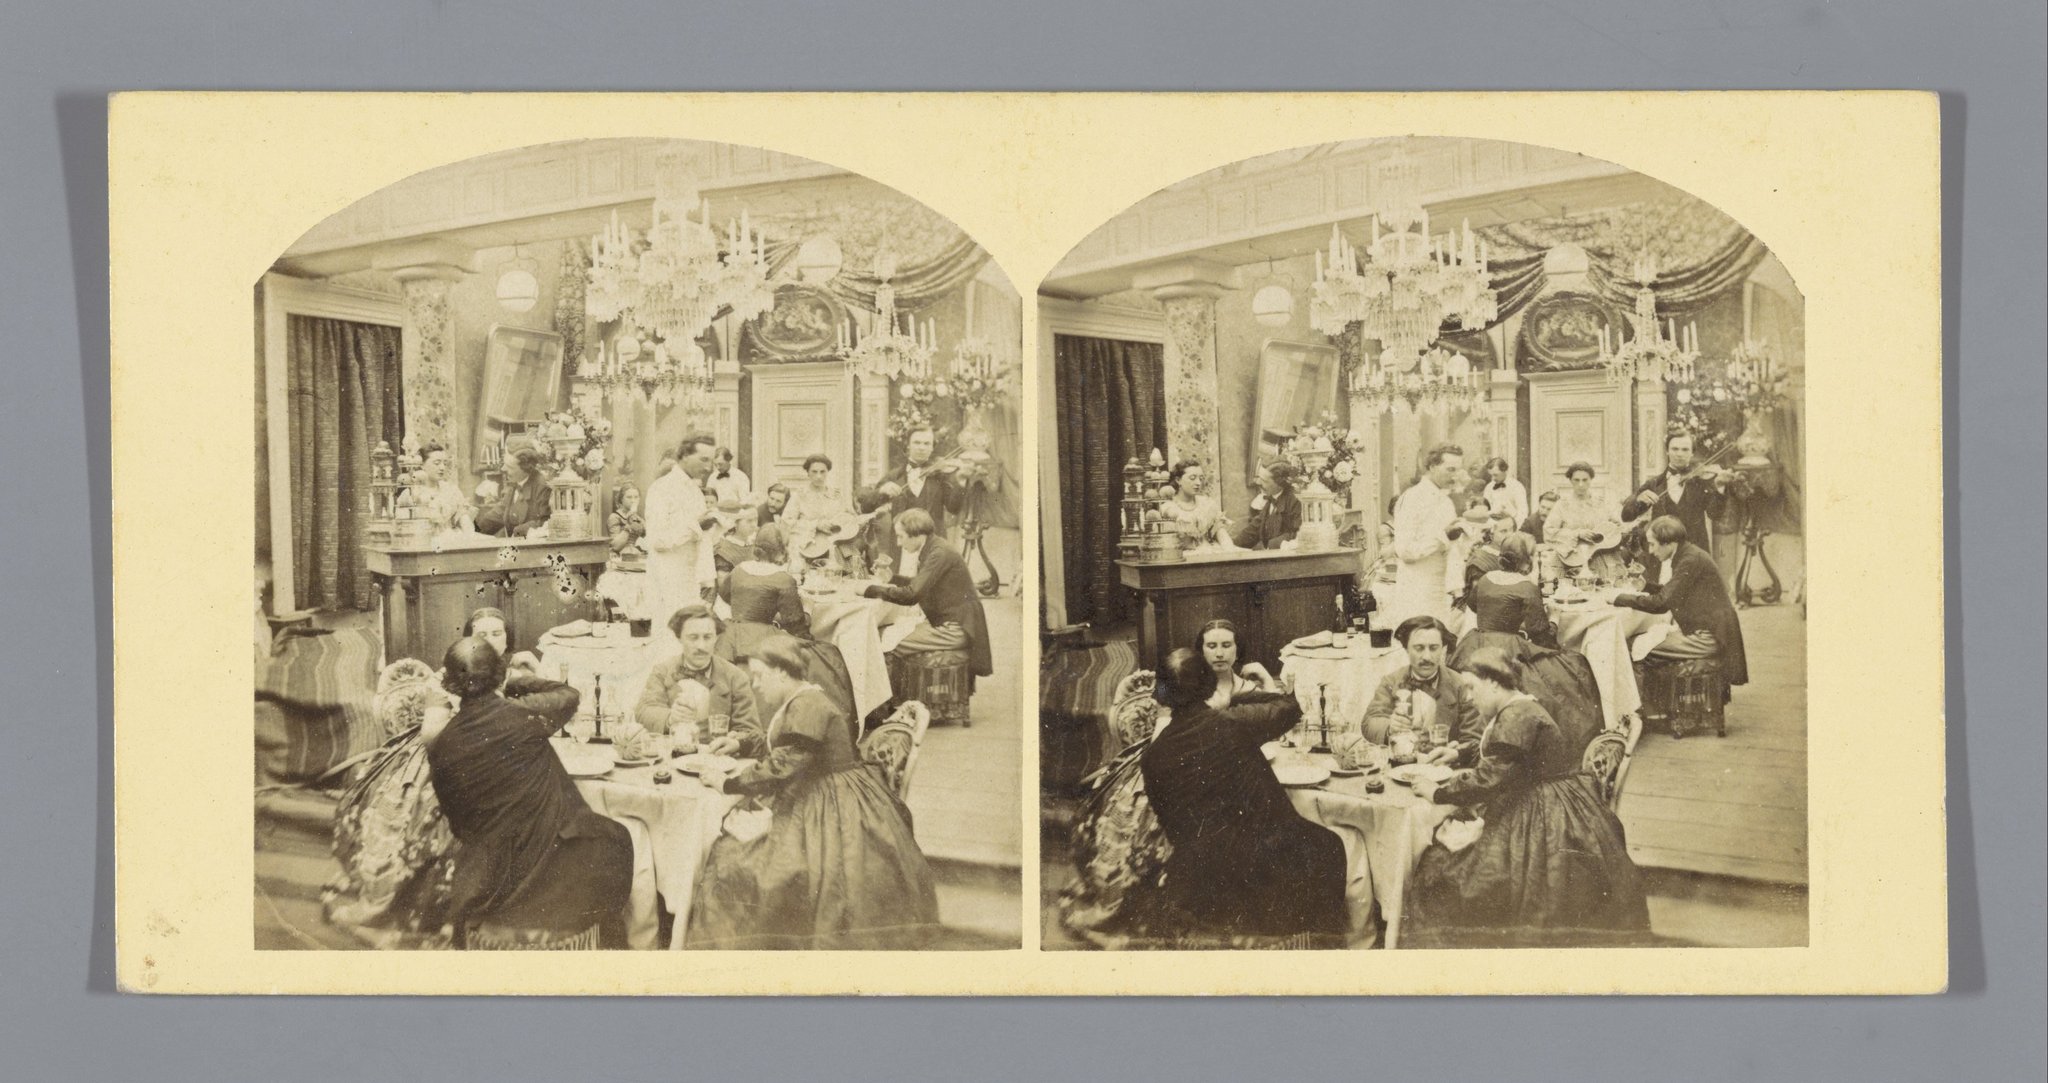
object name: stereograph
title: Interieur van een restaurant met tafels met mensen, een ober en een violist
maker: Anonymous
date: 1850-1880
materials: cardboard, photographic support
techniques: albumen print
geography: europe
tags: violin, fiddle, restaurant, europe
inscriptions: number: ‘136.’